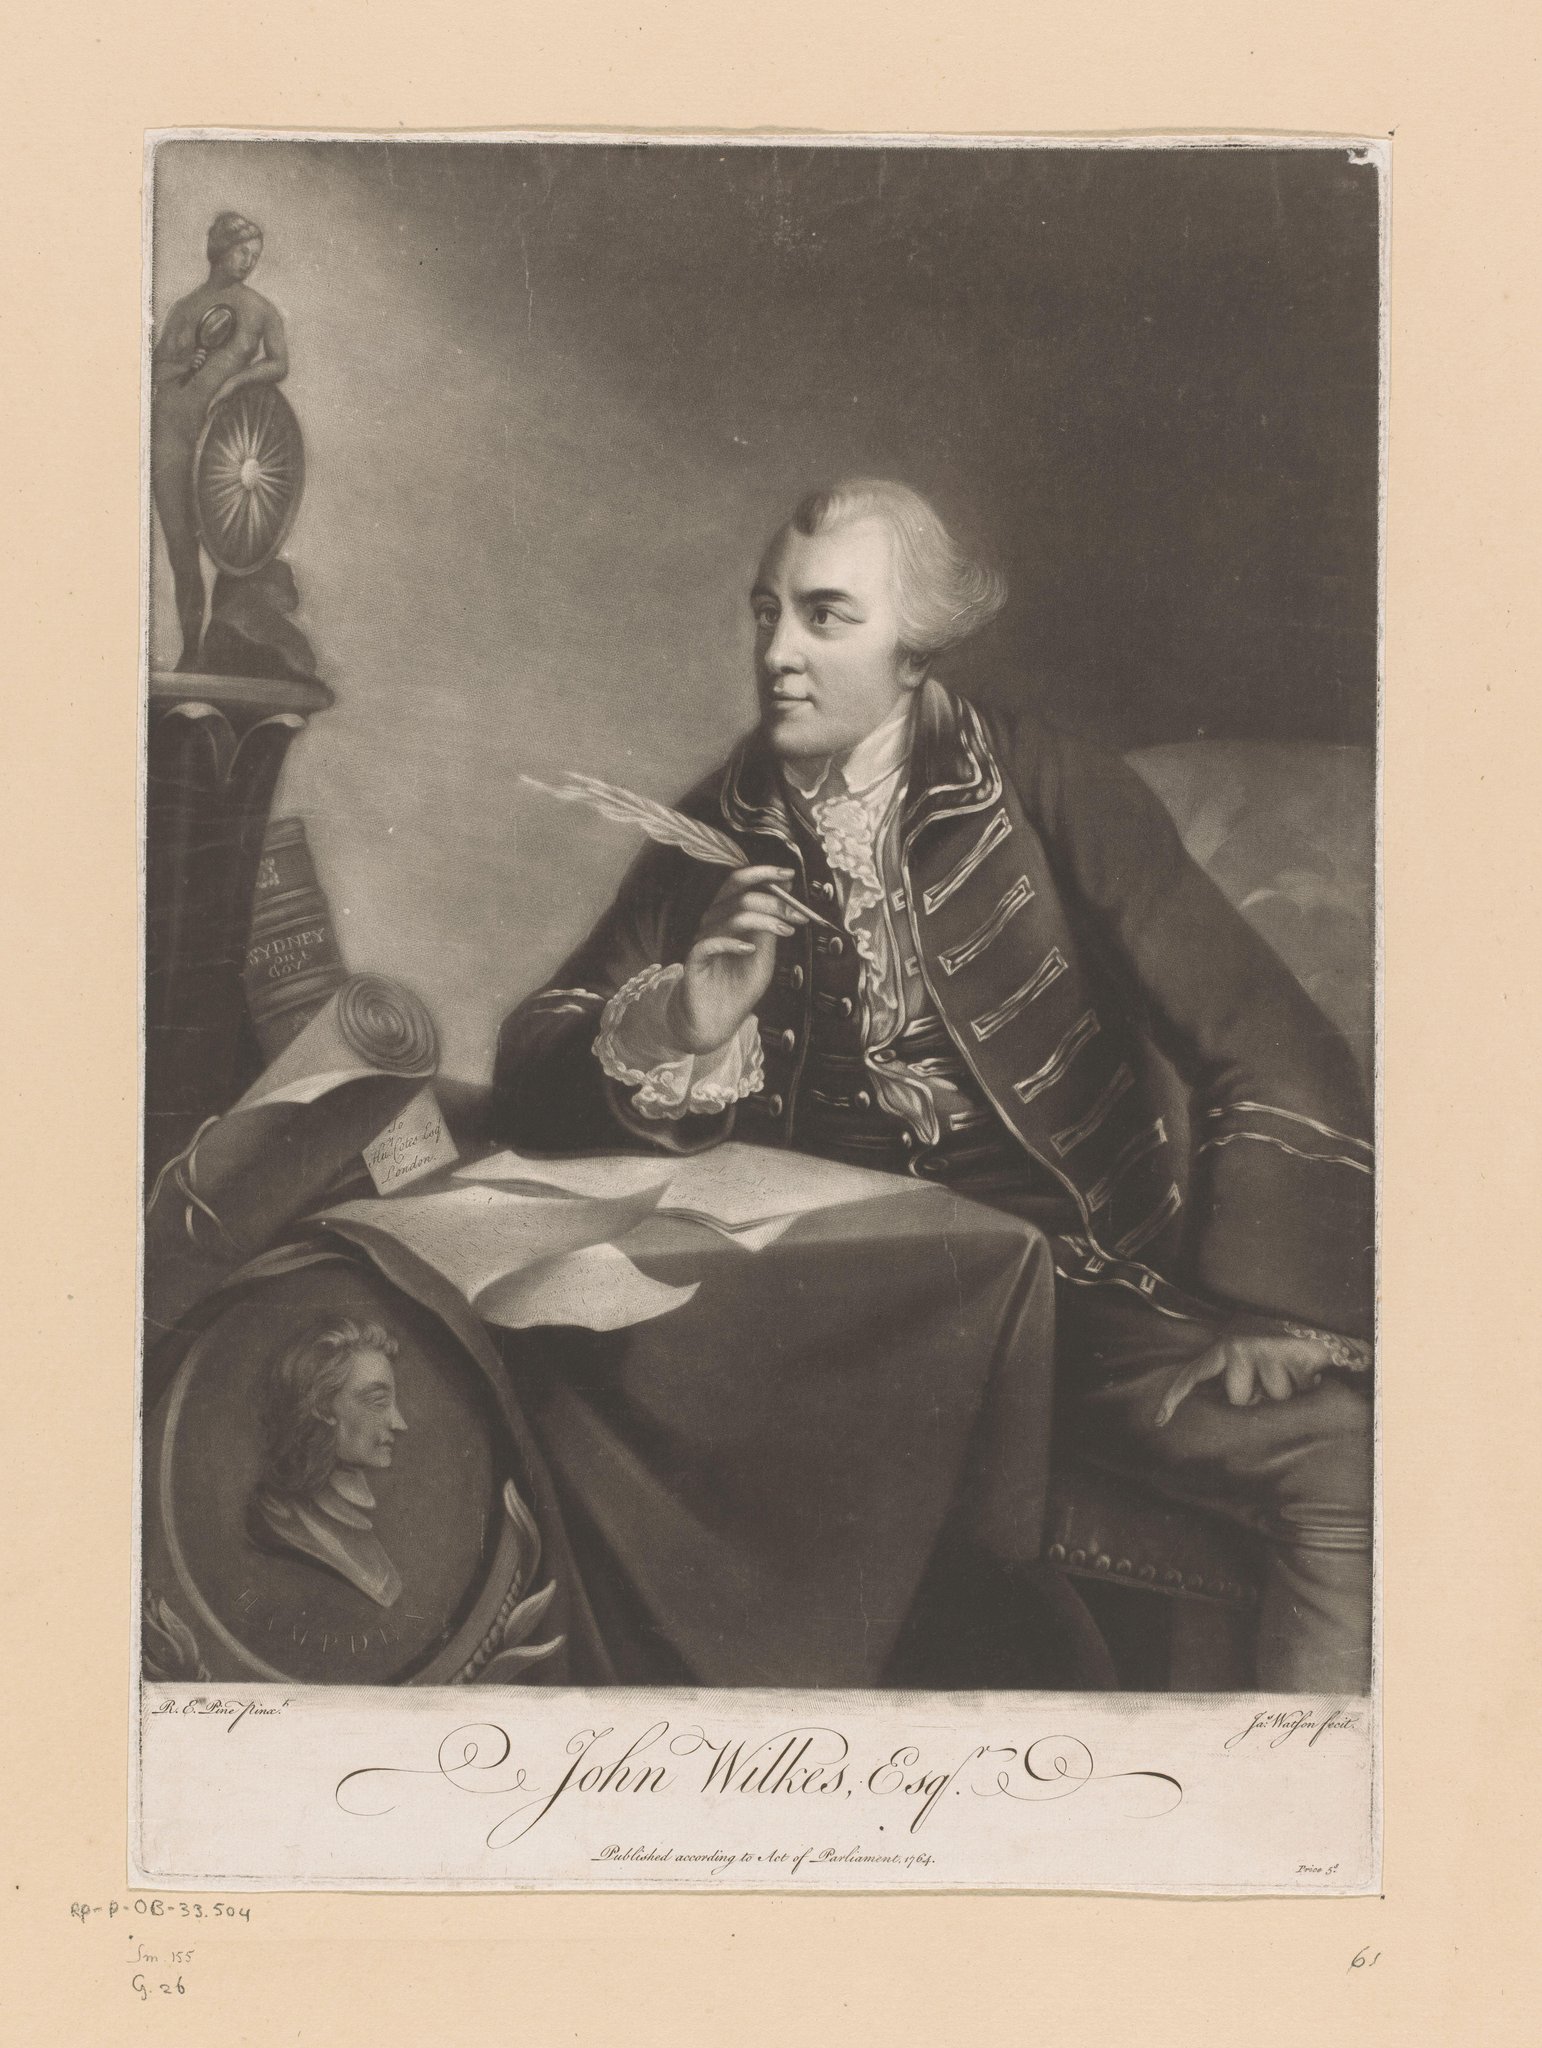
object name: print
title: John Wilkes Esqr.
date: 1764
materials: paper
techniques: mezzotint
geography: london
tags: politician, handwriting, writing as activity, historical persons, book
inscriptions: collector's mark: Lugt 240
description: Linksonder een plaat met een buste in profiel van John Hampden.